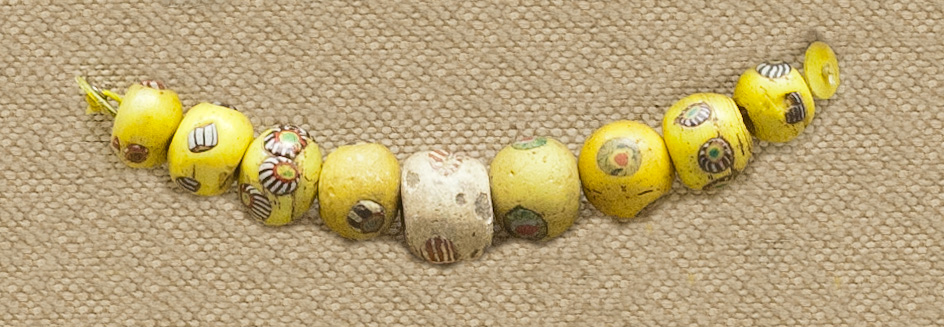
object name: necklace, bead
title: String of 9 Eyed Beads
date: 801-1500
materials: glass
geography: egypt